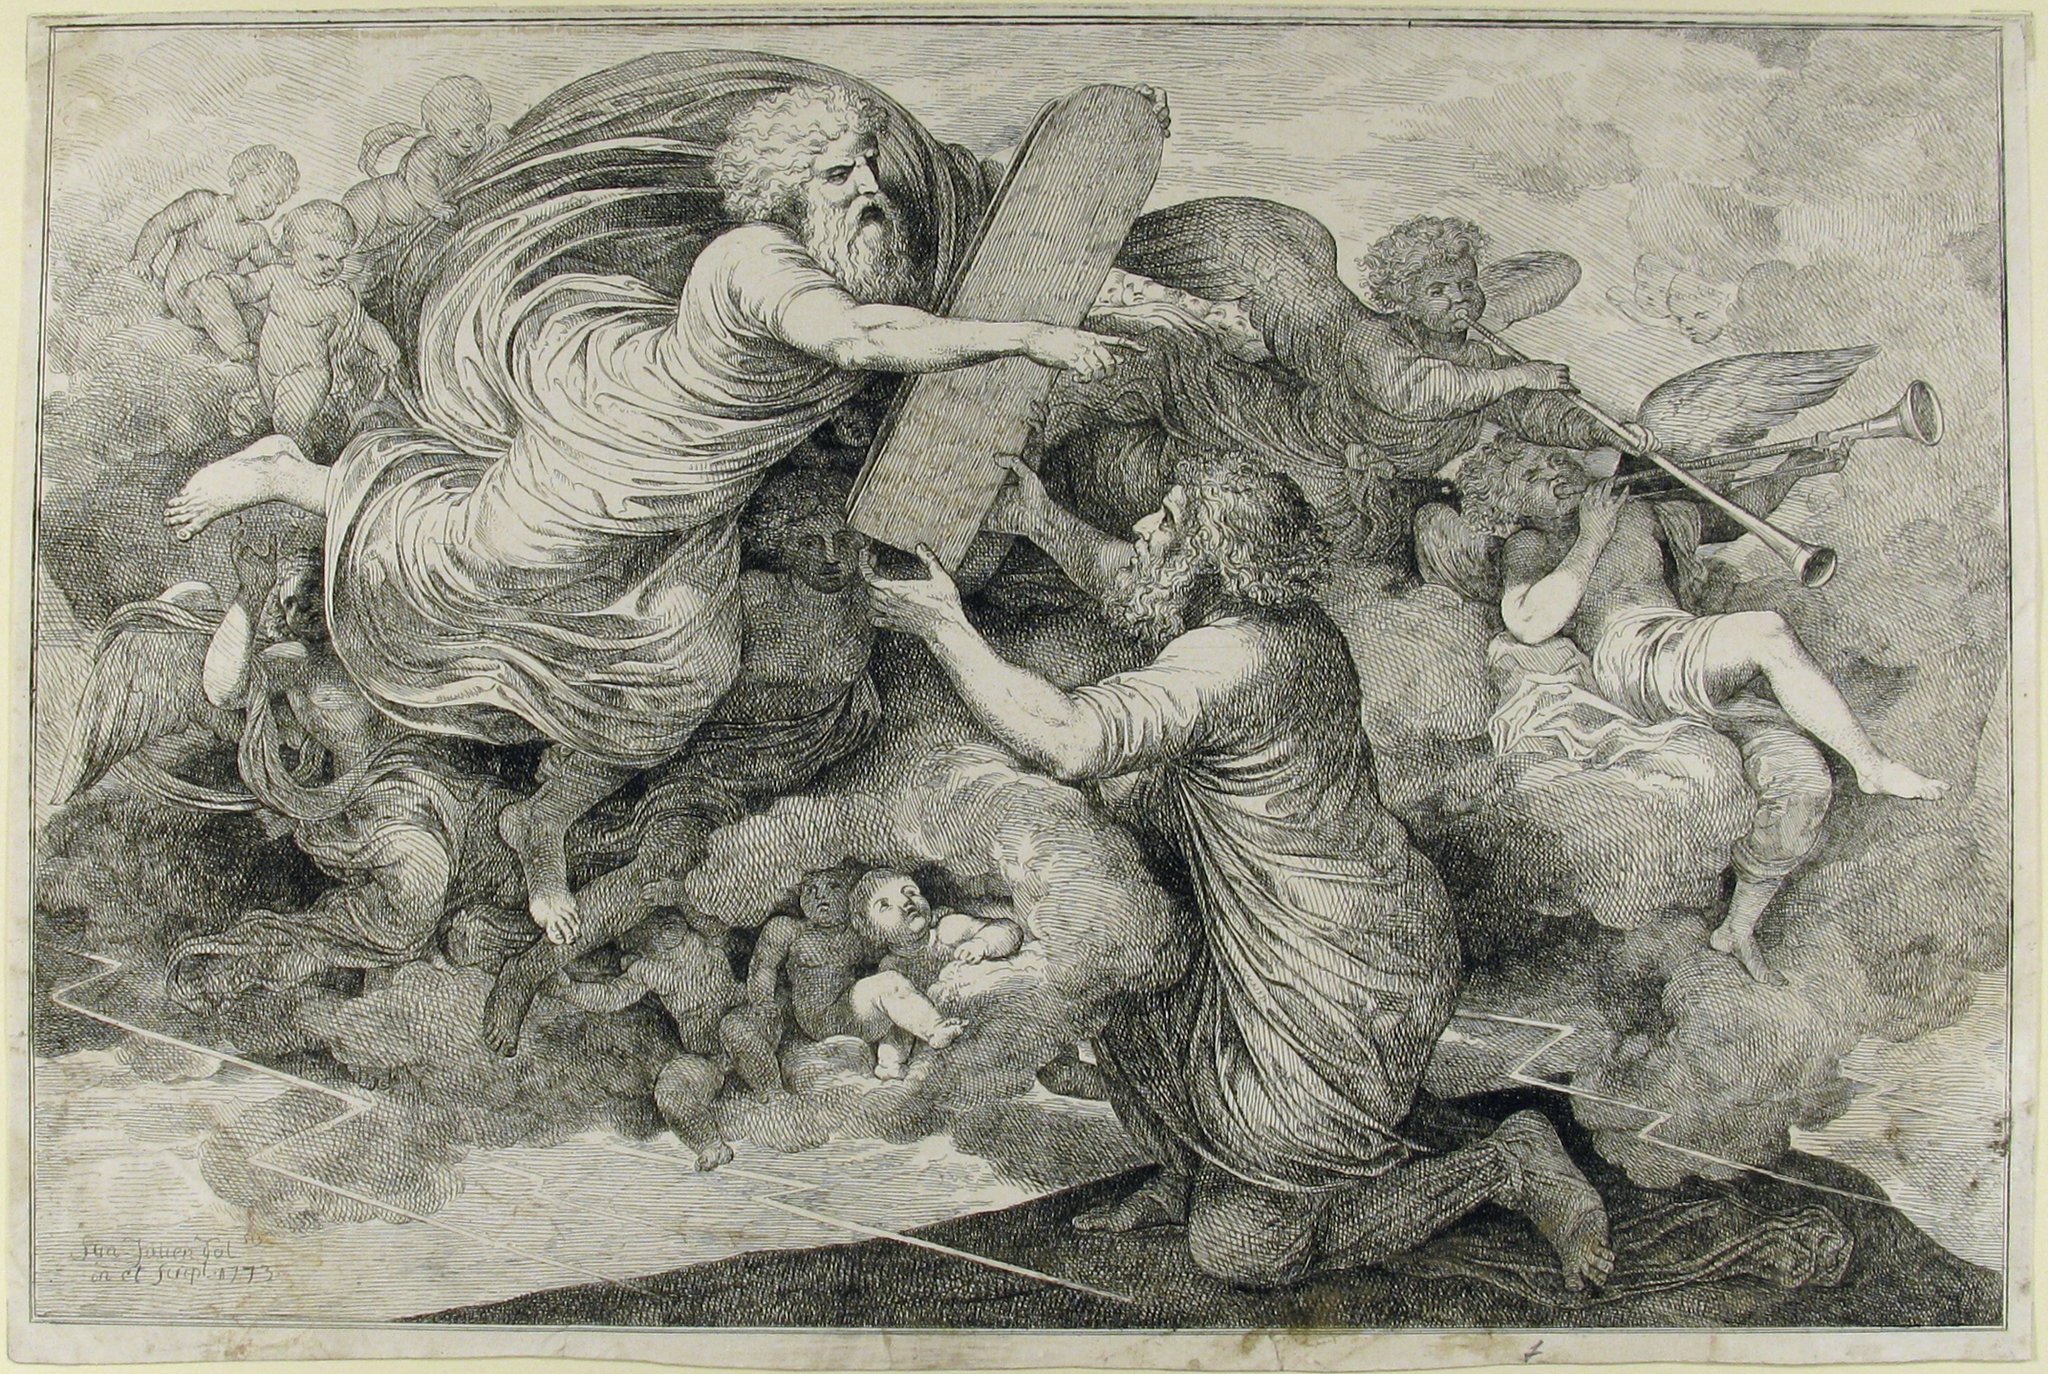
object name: print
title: Moses on Sinai (Le tables de Loi judaique)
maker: simon julien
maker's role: artist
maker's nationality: french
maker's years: 1735-1800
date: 1773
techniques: etching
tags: musical instruments,men,moses